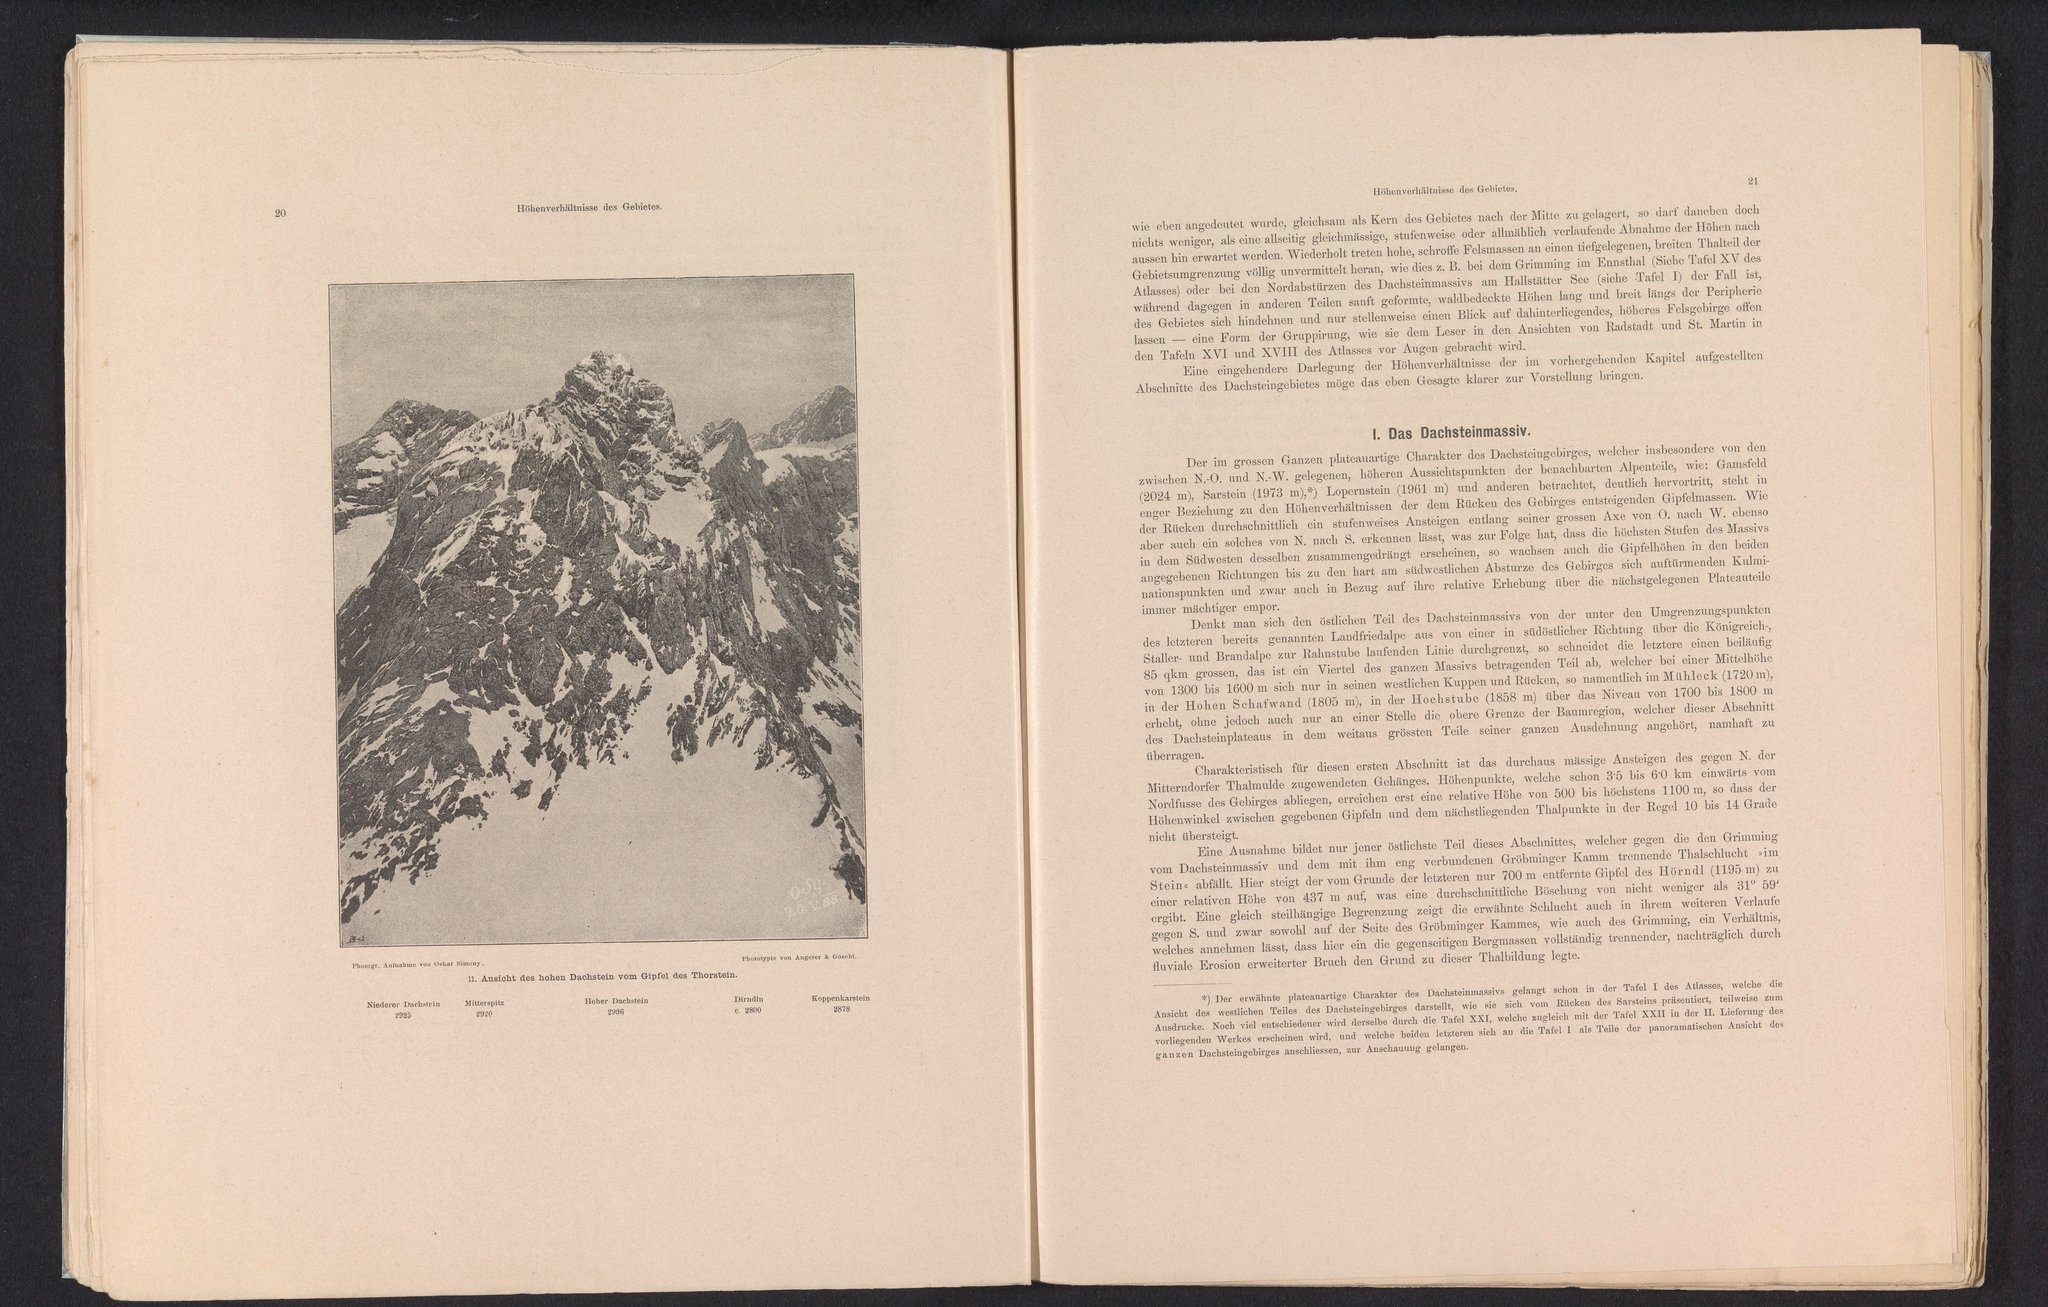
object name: page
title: Ansicht des hohen Dachstein vom Gipfel des Thorstein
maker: oskar simony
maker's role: wiskundige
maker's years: 1852-1915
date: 1888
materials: paper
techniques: autotype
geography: salzburg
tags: mountain-range, snow peaks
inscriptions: number: ‘11.’